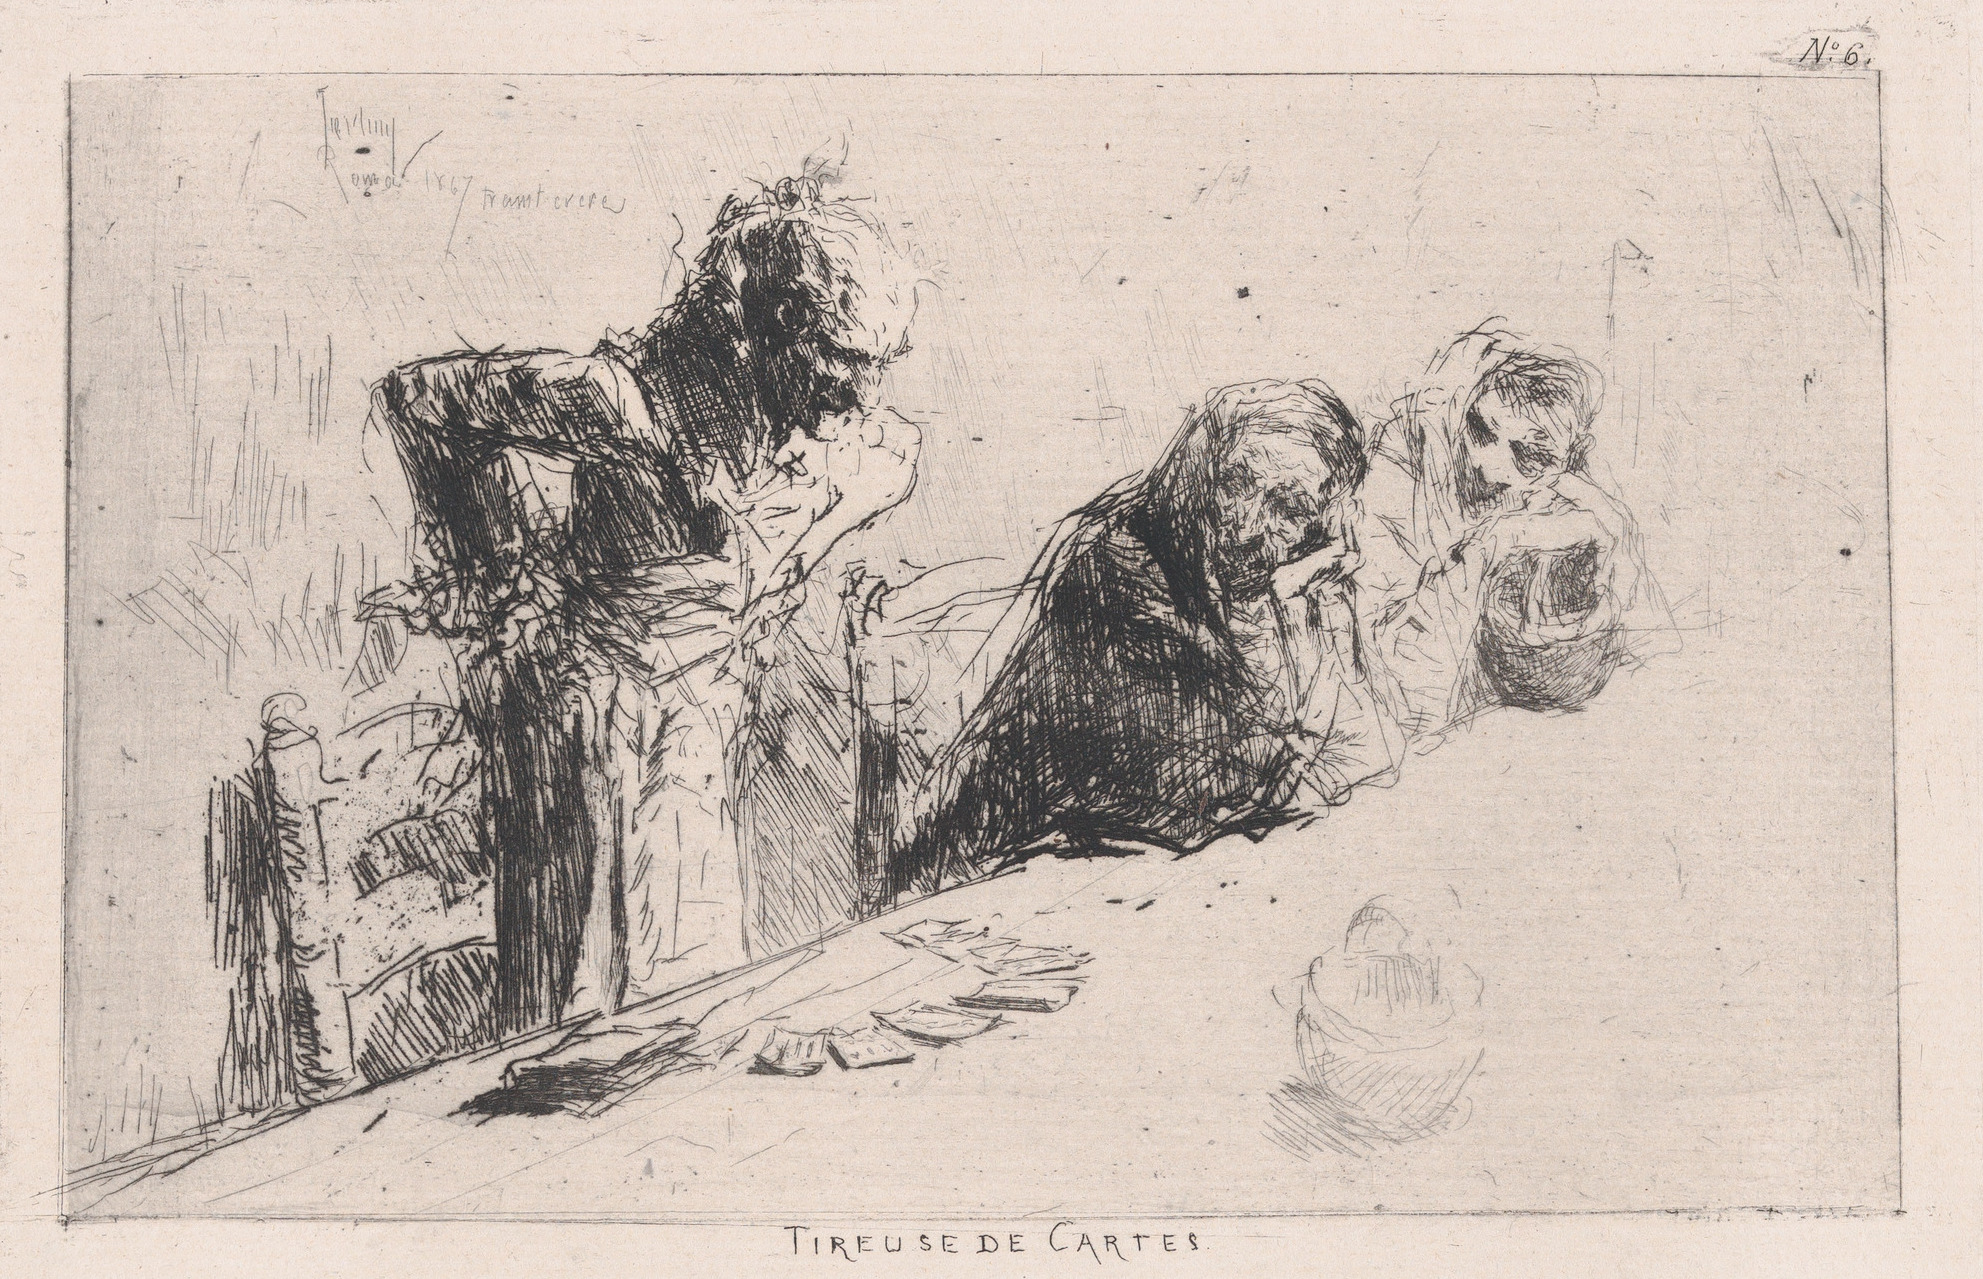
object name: print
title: Cardplayers: three men, two seated one standing before a spread of cards on a table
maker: mariano fortuny, 1838–1874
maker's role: artist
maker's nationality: spanish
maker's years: 1838-1874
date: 1867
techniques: etching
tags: men,playing cards